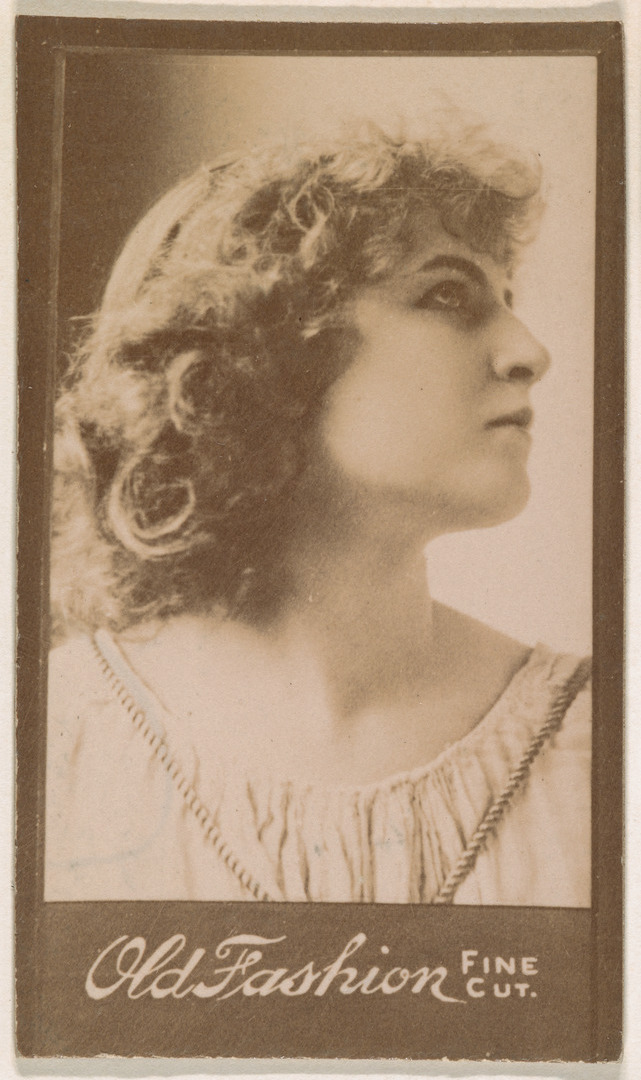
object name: photograph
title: Portrait of actress in profile, from the Actresses series (N664) promoting Old Fashion Fine Cut Tobacco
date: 1888-1890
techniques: albumen silver print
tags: portraits,women,actresses